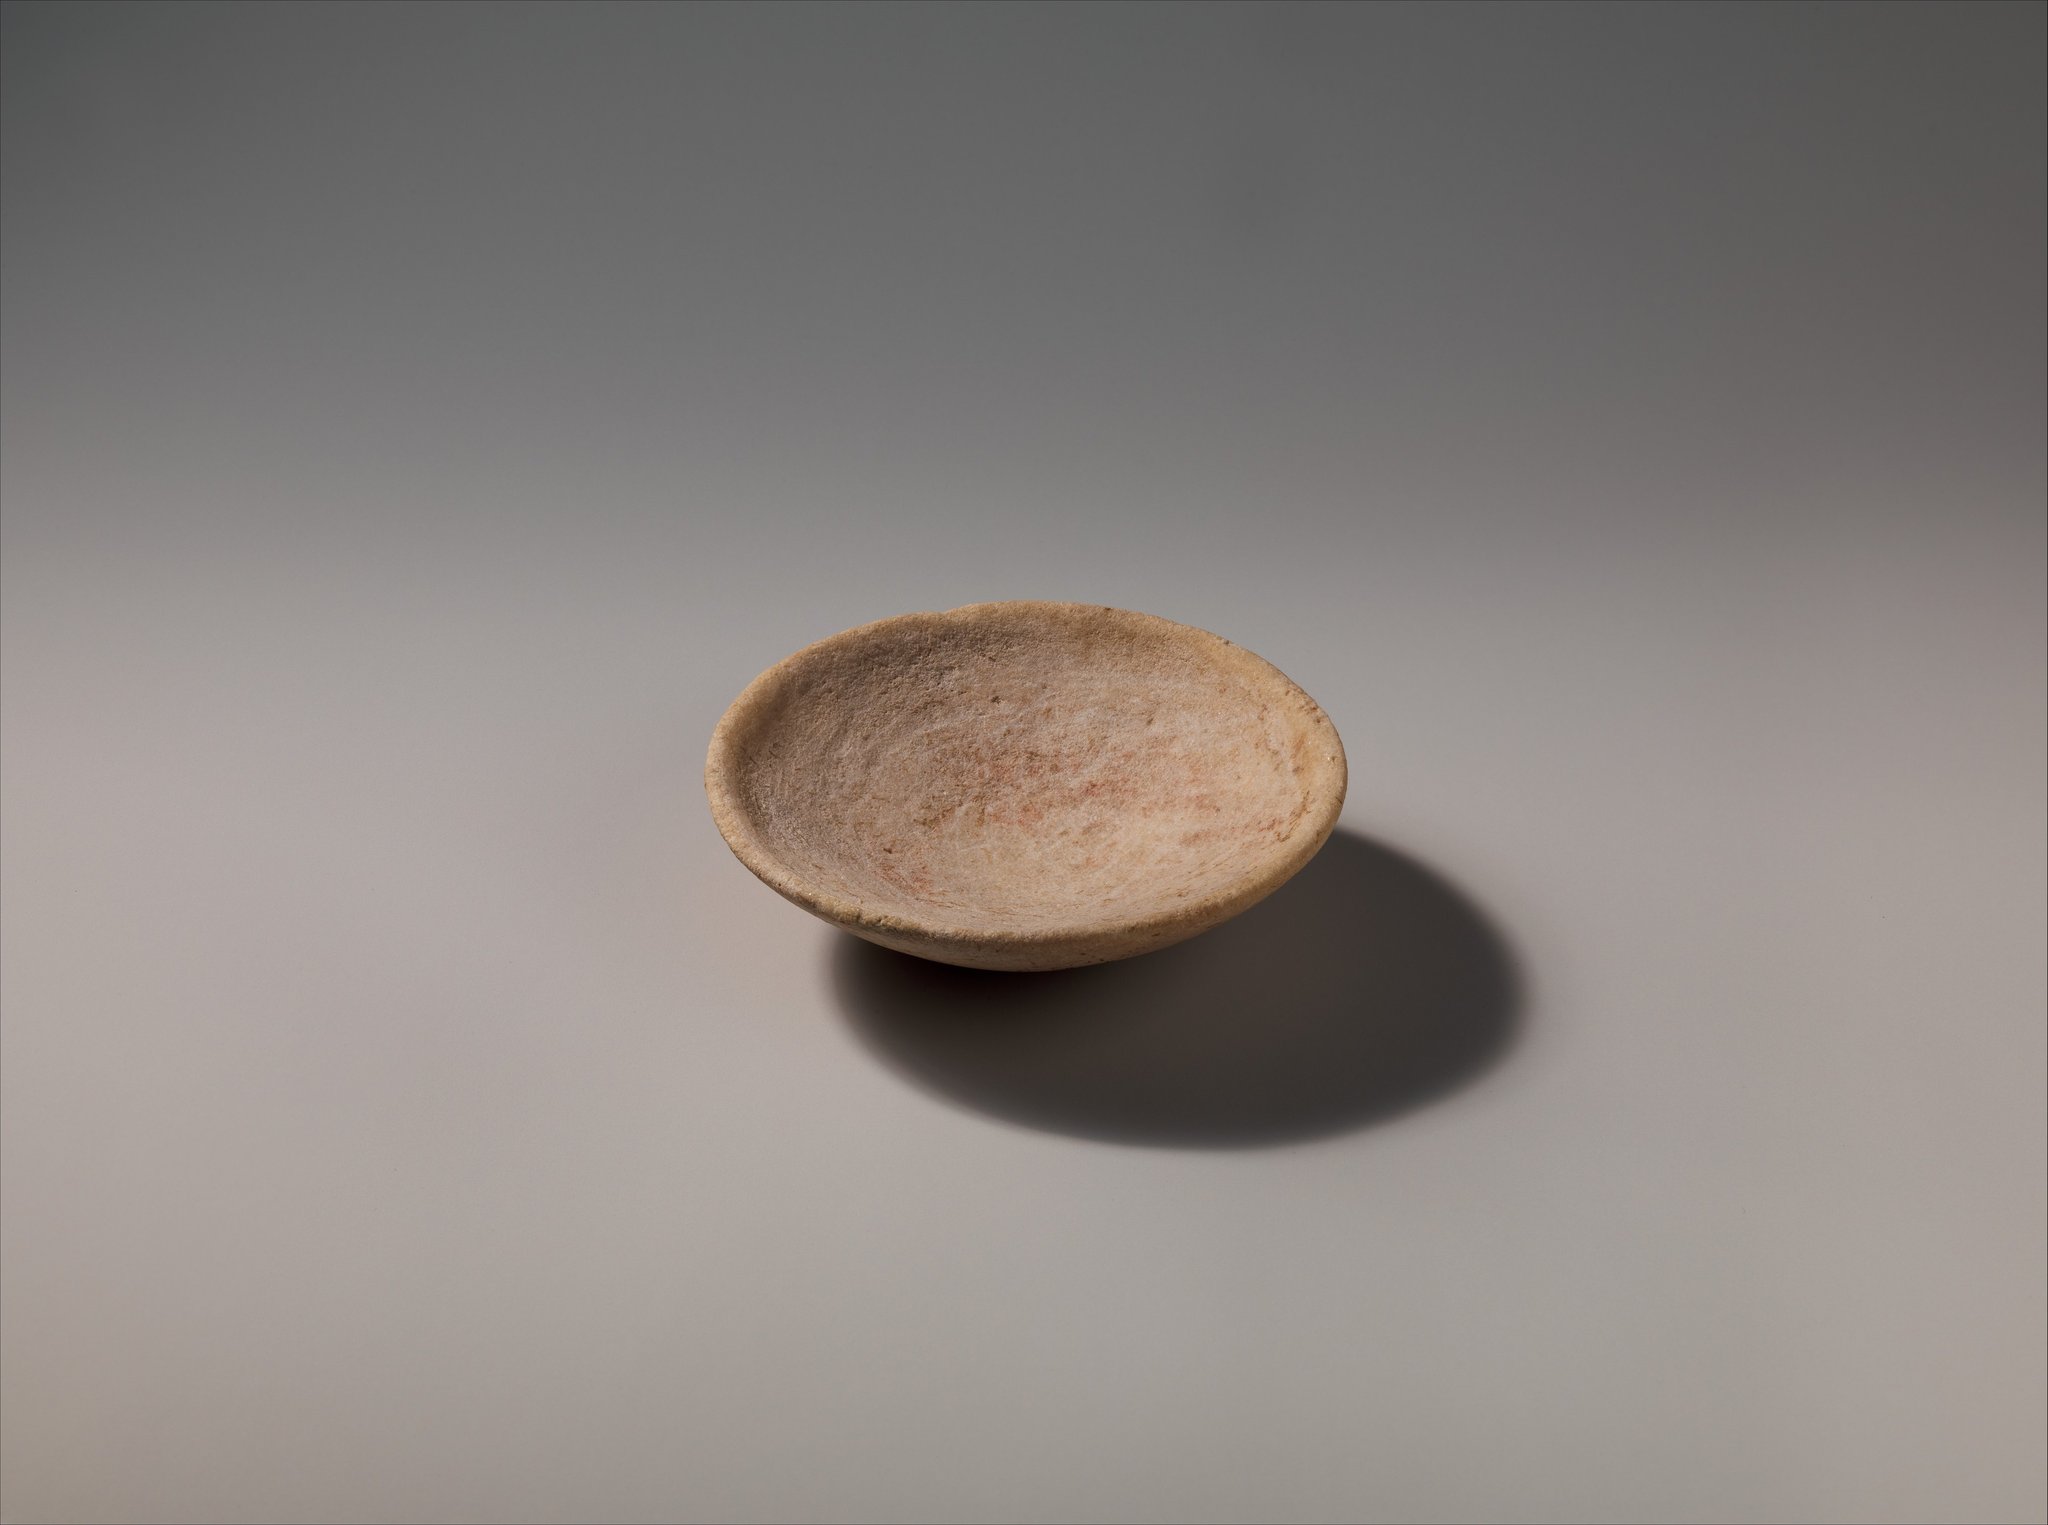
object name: bowl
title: Marble bowl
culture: cycladic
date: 2800-2500 BCE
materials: marble, pigment